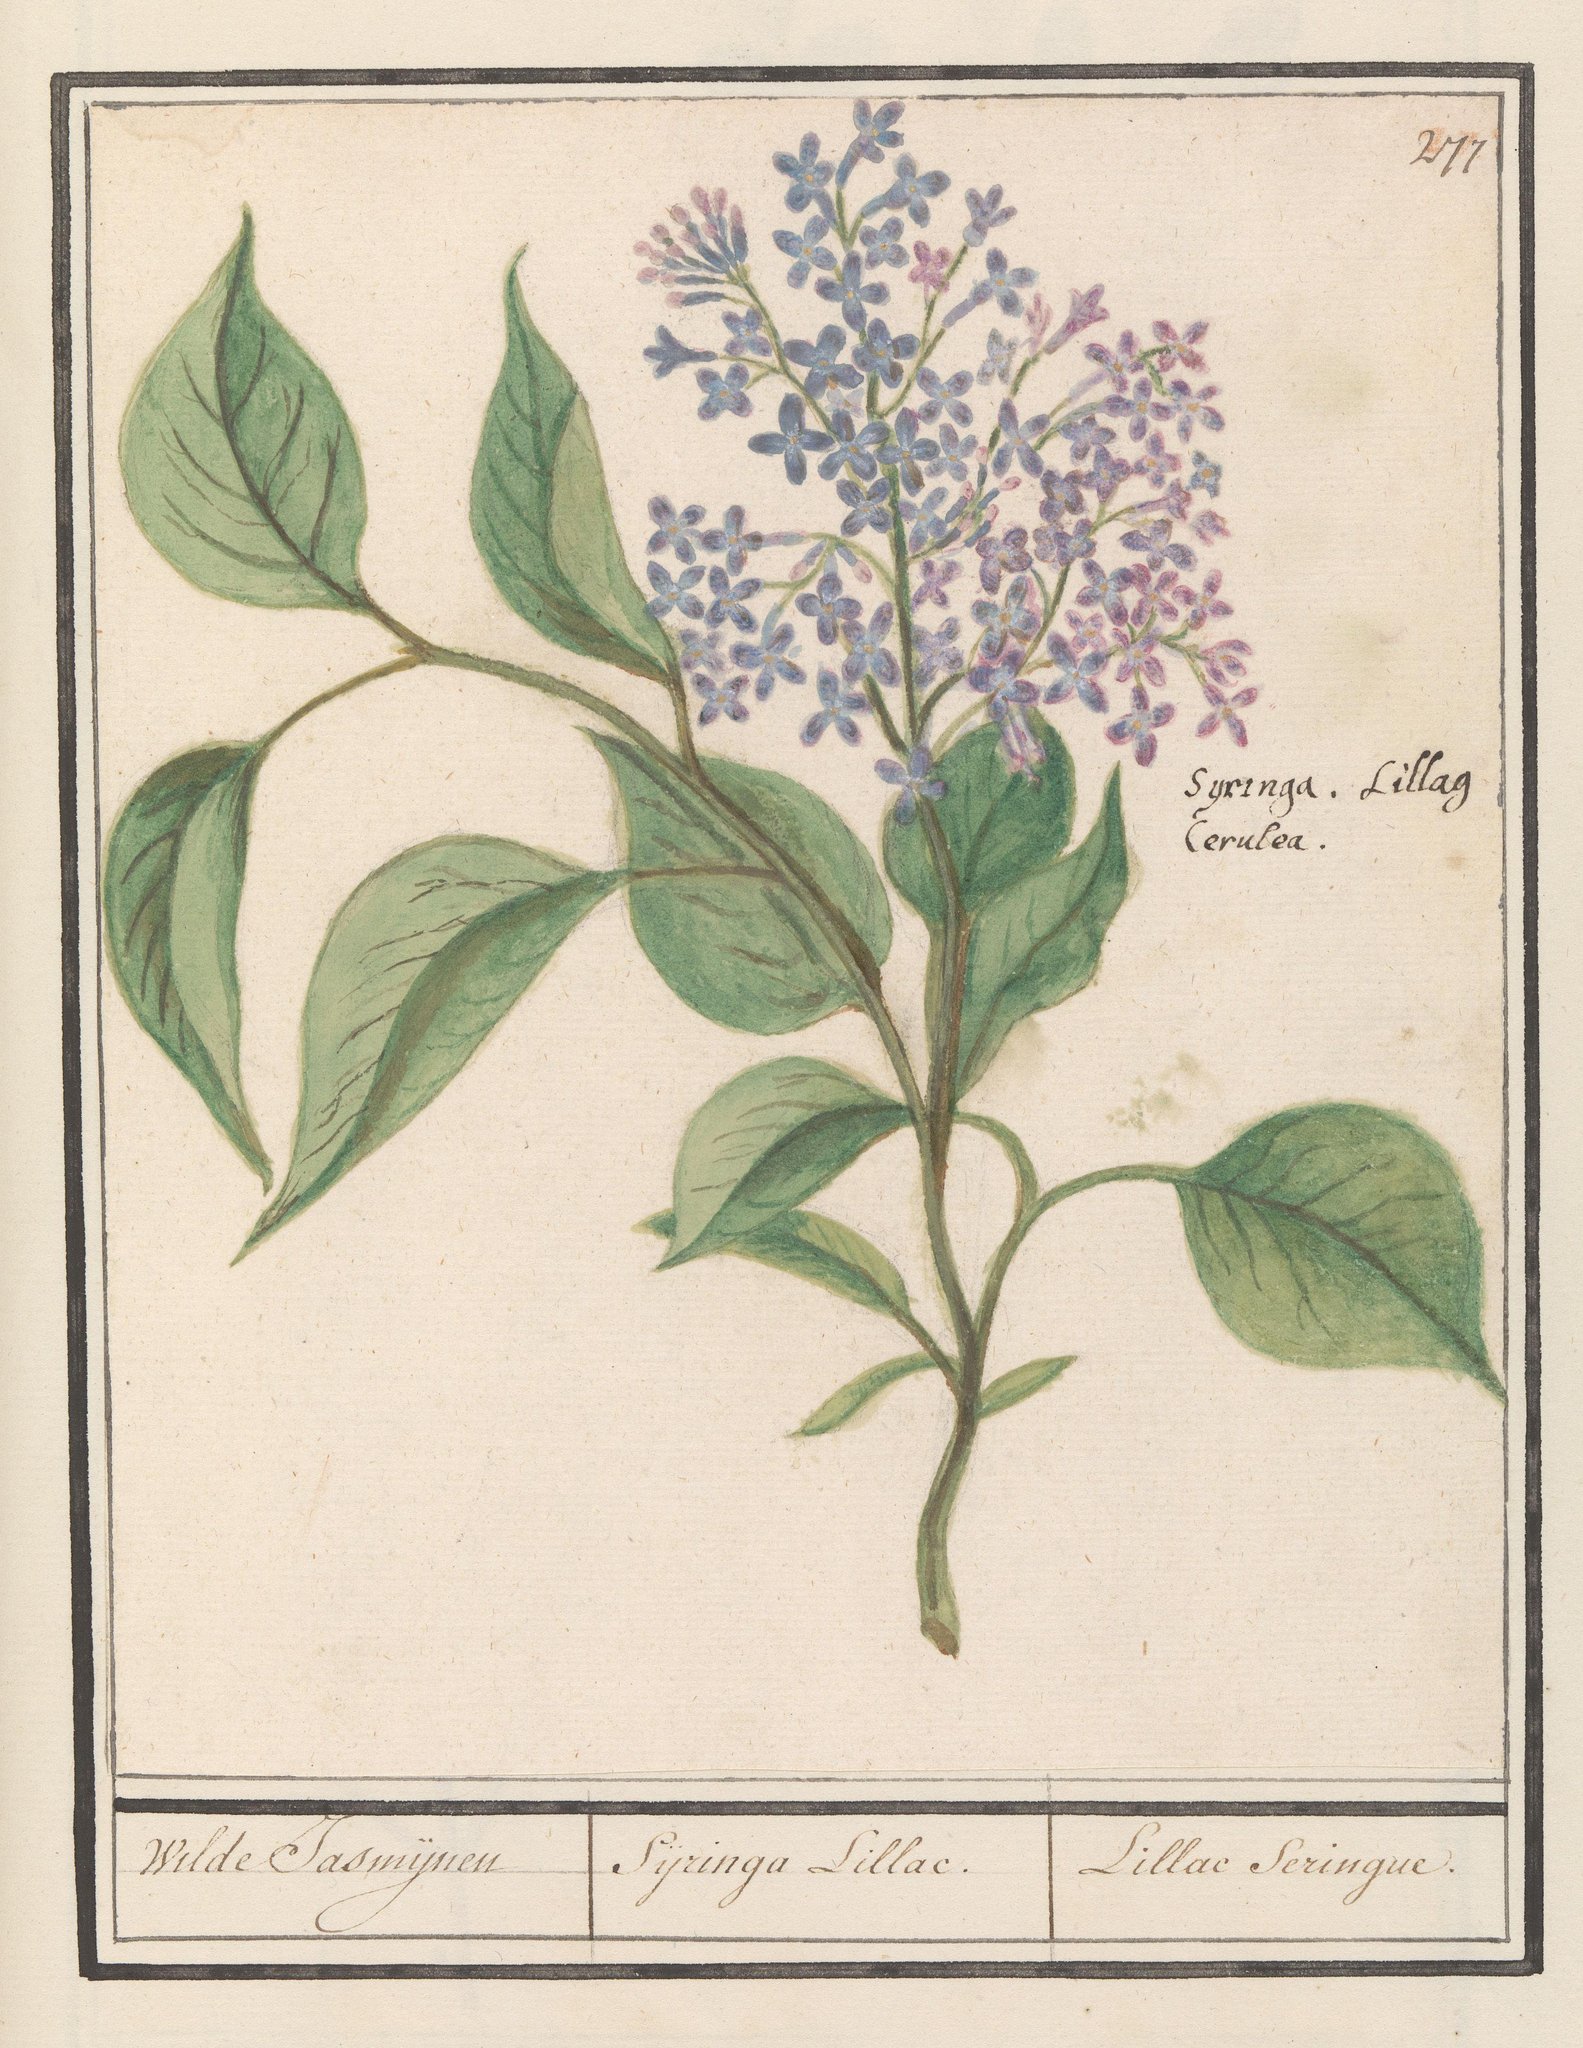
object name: drawing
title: Sering (Syringa vulgaris)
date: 1596-1610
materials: chalk, paint, ink, paper, watercolor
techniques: brush, pen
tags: flowers: lilac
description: Sering. Genummerd rechtsboven: 277. Rechts de Latijnse naam. Onderdeel van het derde album met tekeningen van bloemen en planten. Tiende van twaalf albums met tekeningen van dieren, vogels en planten bekend rond 1600, gemaakt in opdracht van keizer Rudolf II. Met toelichting in Nederlands, Latijn en Frans.